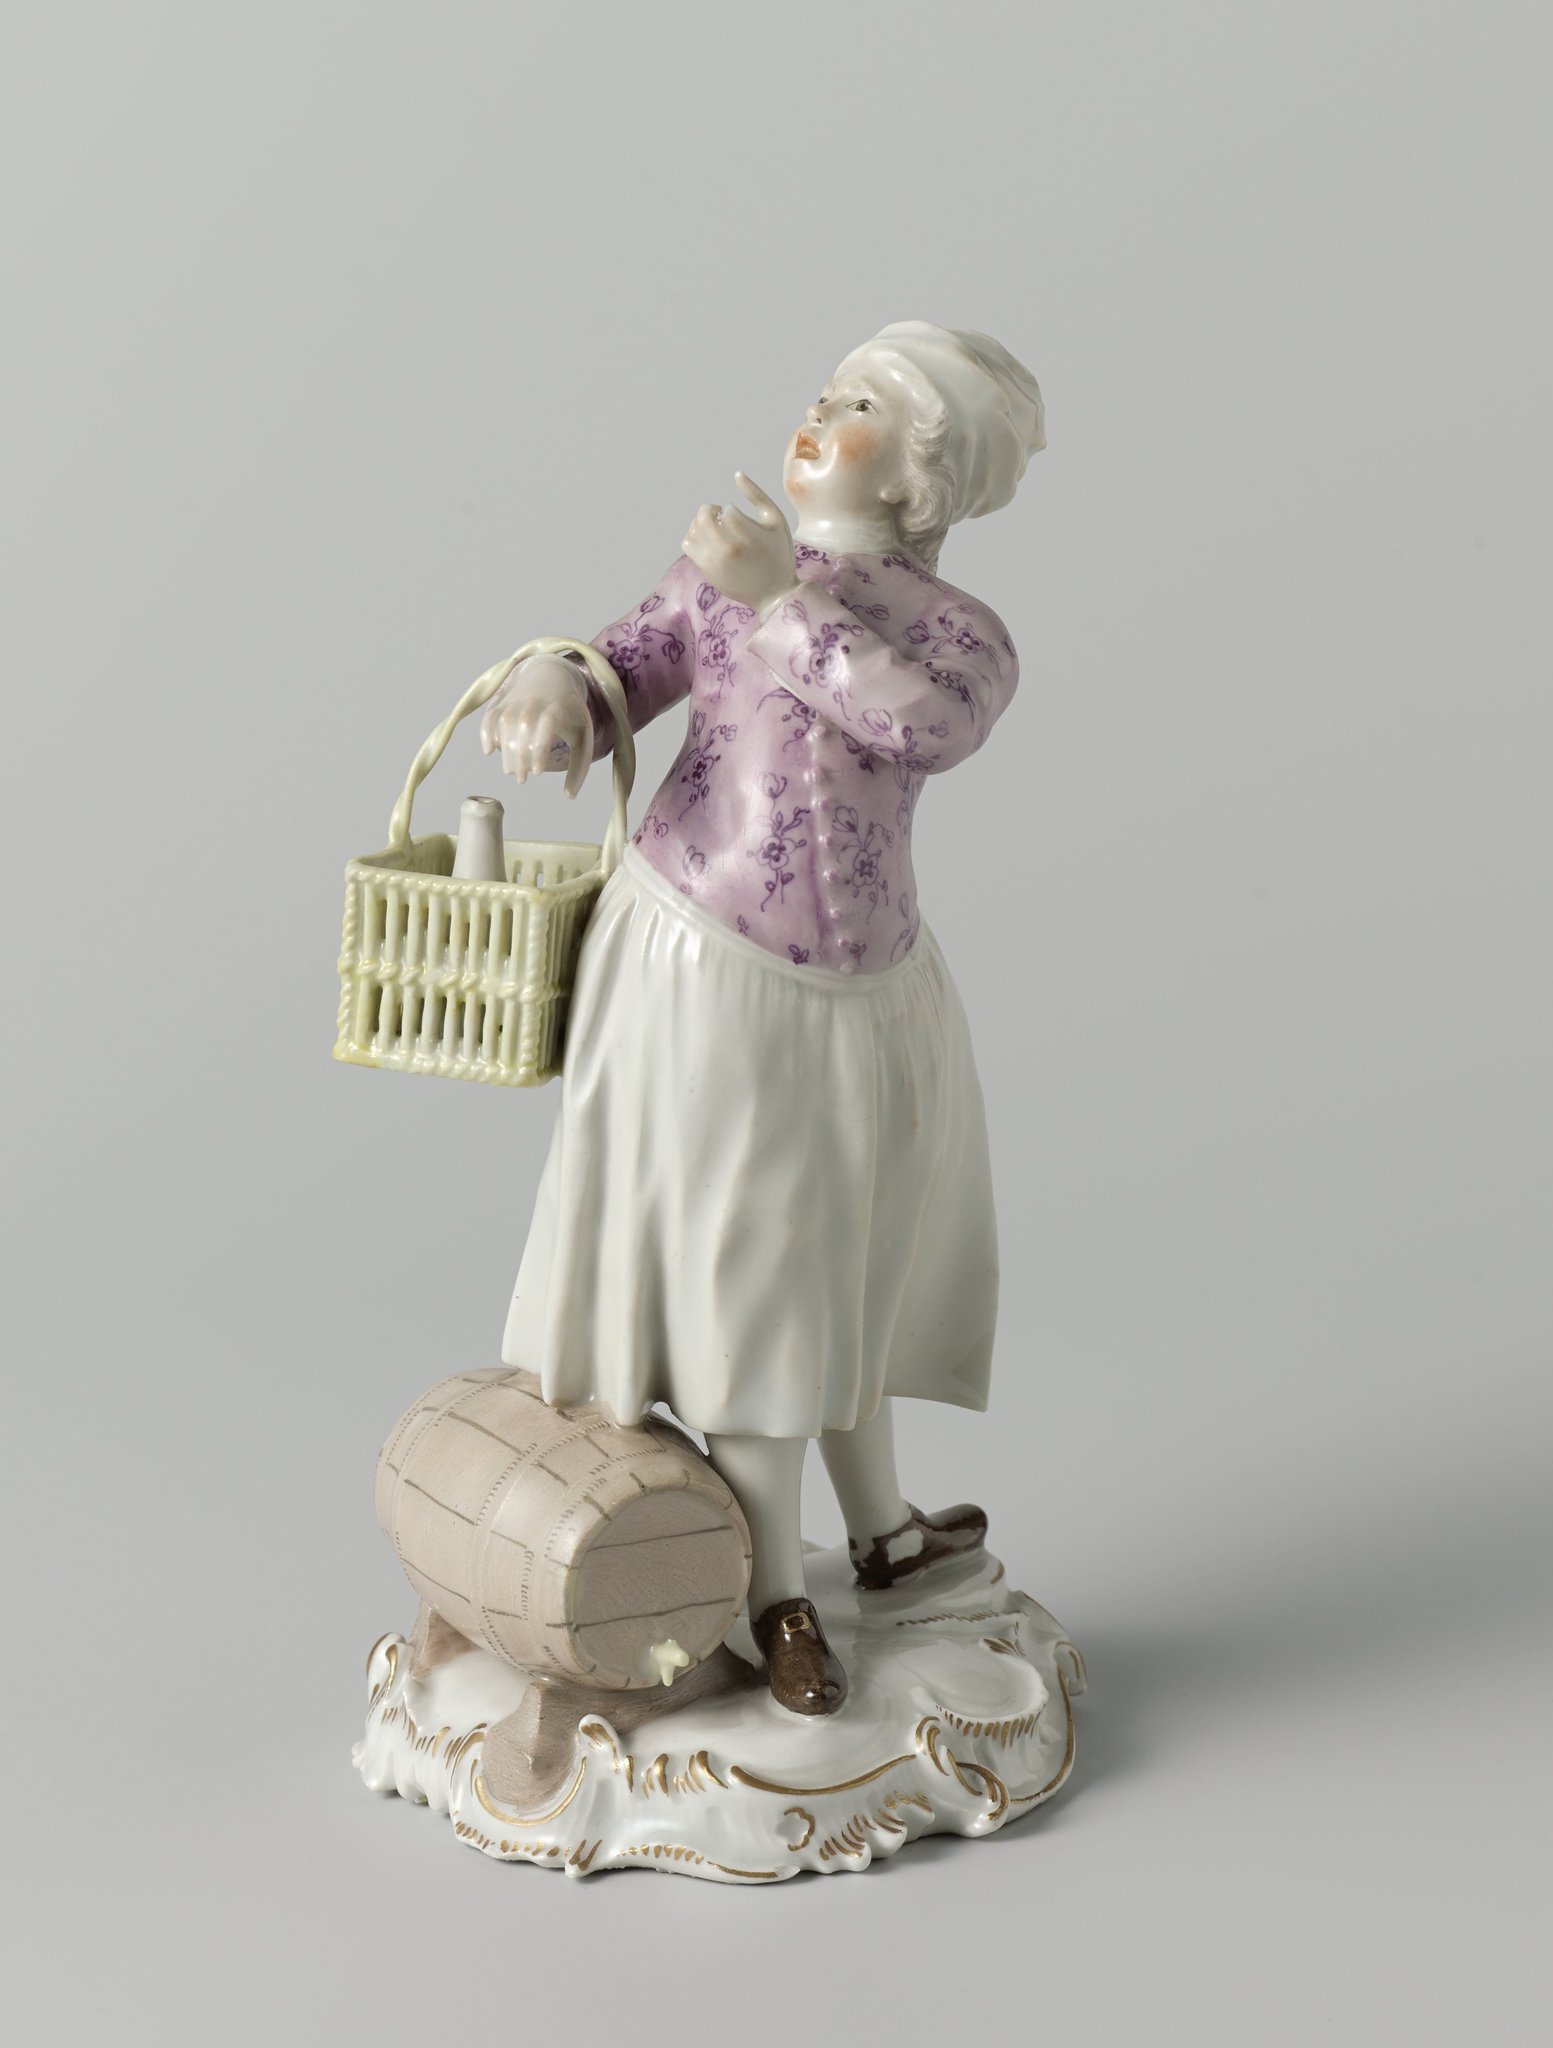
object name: figure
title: Figure of a merchant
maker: johann wilhelm lanz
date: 1759-1762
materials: glaze, gold, paint, porcelain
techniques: firing, forming, gilding, vitrification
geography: frankenthal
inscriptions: mark: ‘leeuw’, monogram: ‘J.A.H.’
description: Figuur, voorstellend een marktkoopman. Porselein, Frankenthal, ca. 1759 - 1762, het model toegeschreven aan Johann Wilhelm Lanz.